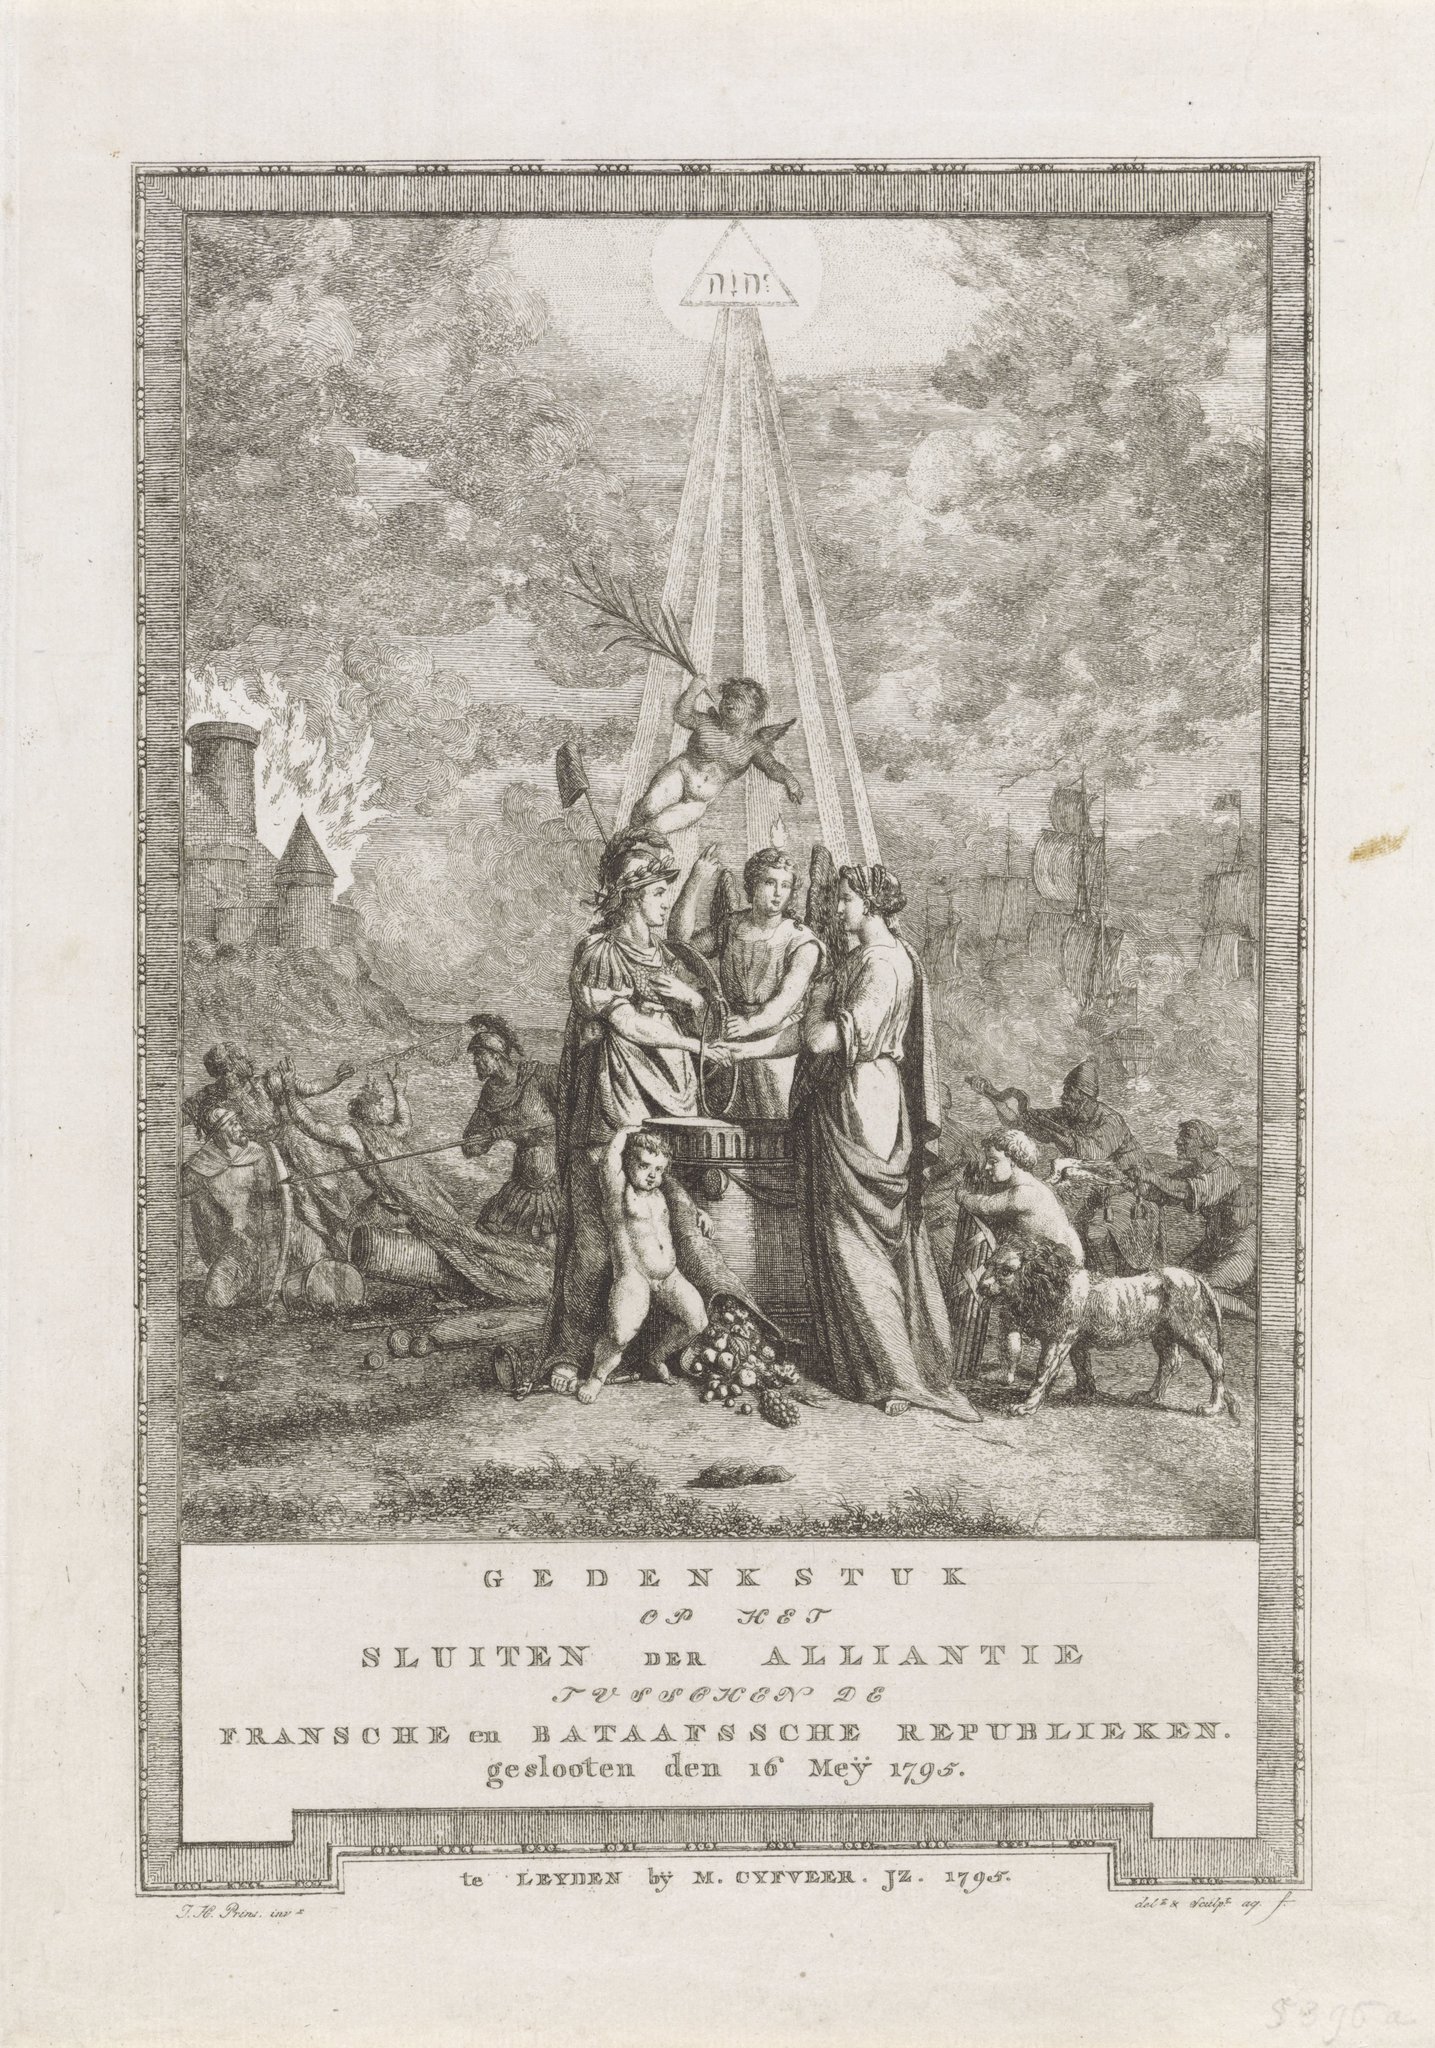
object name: print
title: Gedenkstuk op het Sluiten der Alliantie tusschen de Fransche en Bataafssche Republieken. geslooten den 16 Mey 1795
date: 1795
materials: paper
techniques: etching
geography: netherlands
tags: freedom, liberty; 'libertà' (ripa) (+ symbolical representation of concept), alliance, league, union, foedus, alliance with france (1795)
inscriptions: collector's mark: Lugt 2228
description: Allegorie op het sluiten van de Alliantie tussen de Bataafse en Franse Republieken, 16 mei 1795. De engel van de vrijheid zegent het eeuwige verbond tussen de Franse en de Nederlandse Maagd. Op de achtergrond oorlog ter land en ter zee, links worden List en Bedrog verjaagd.